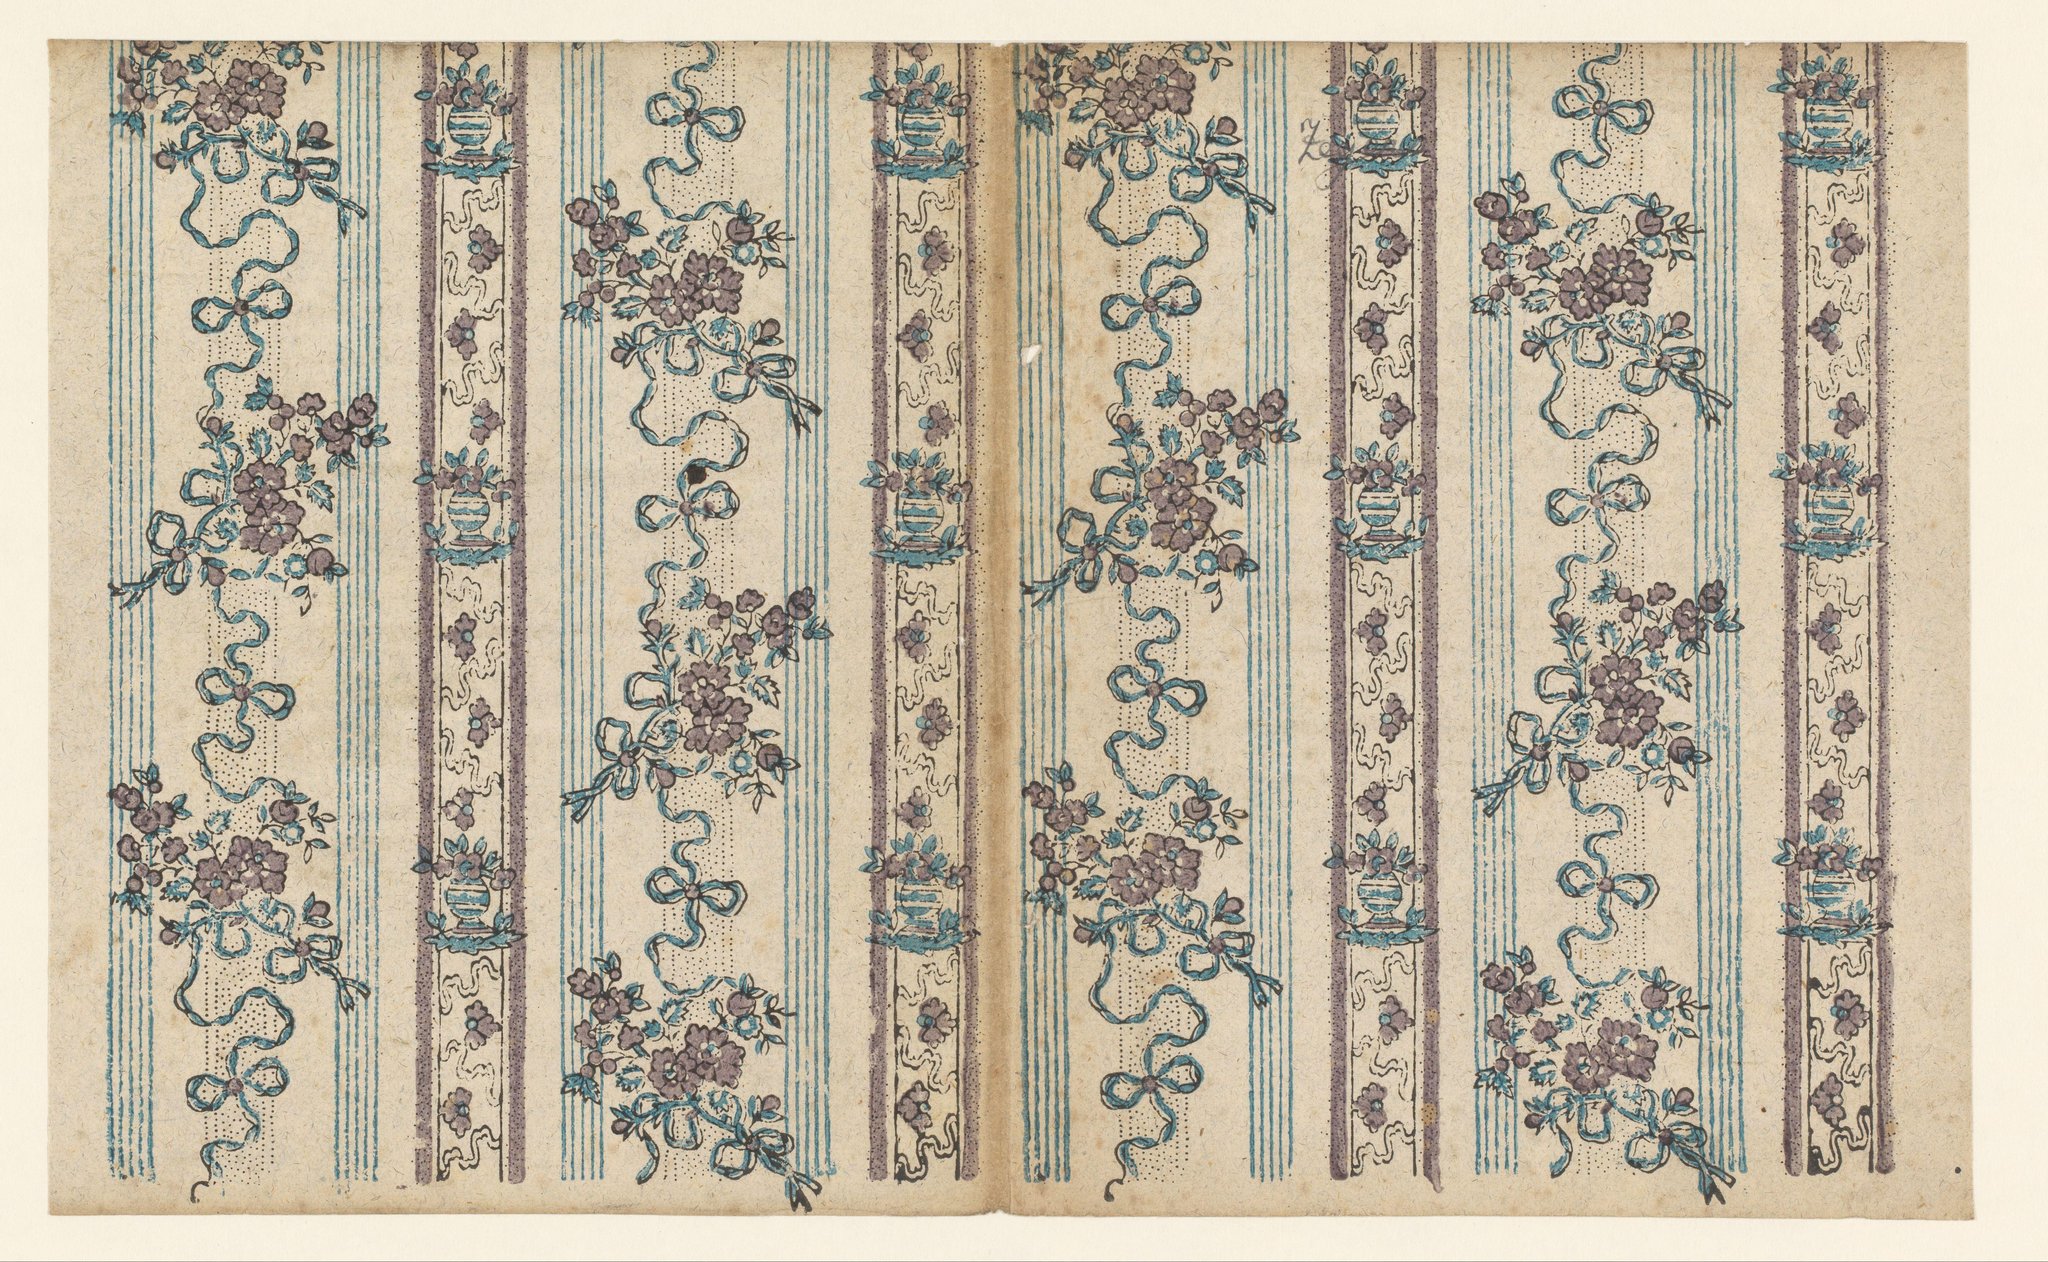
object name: wrapper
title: Blad met banenpatroon met boeketten met strikken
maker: Anonymous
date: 1780-1820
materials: paper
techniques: printing block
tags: ornament derived from plant forms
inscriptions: annotation: ‘Dissert. Zegers Utr. 1800’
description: Blad met verticaal banenpatroon met bloemboeketten met strikken tussen banen met vazen. Gebruikt als omslag voor een publicatie uit 1800.